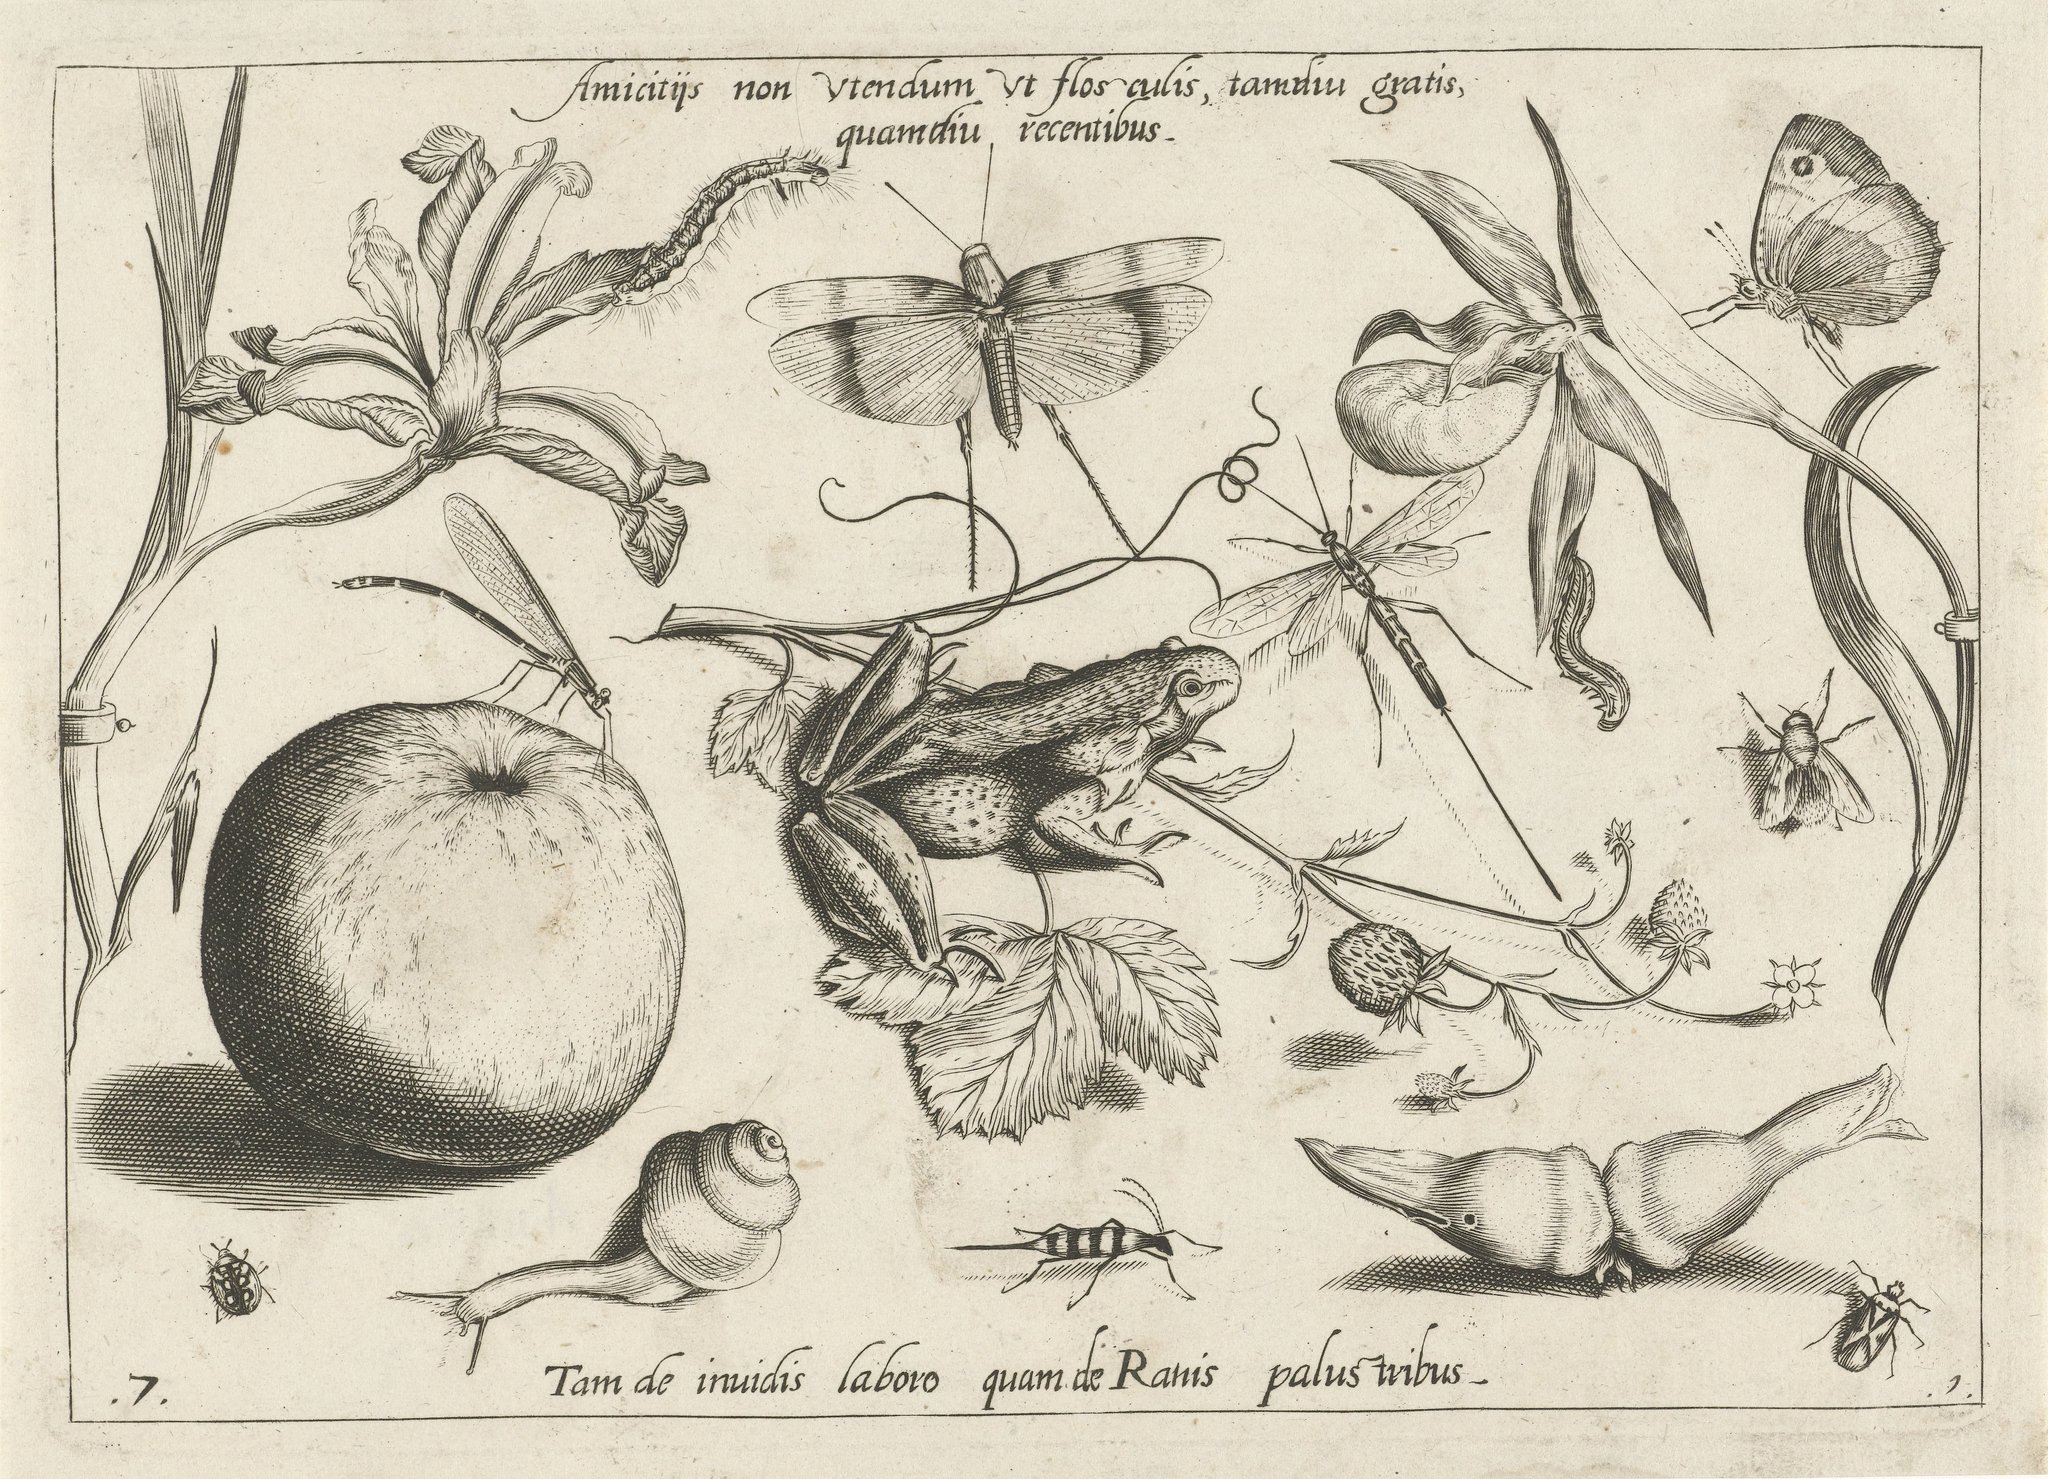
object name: print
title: Insecten, bloemen en vruchten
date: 1592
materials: paper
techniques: engraving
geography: nuremberg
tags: tailless amphibians: frog, fruits: apple, plants and herbs: garlic, fruits: hazelnut, insects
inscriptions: collector's mark: Lugt 2228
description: Prent uit een serie van 48 prenten, opgedeeld in vier afzonderlijke delen van elk twaalf prenten. Rechtsonder vermeld: [deel] 1. Boven- en onderaan een tekst in het Latijn.